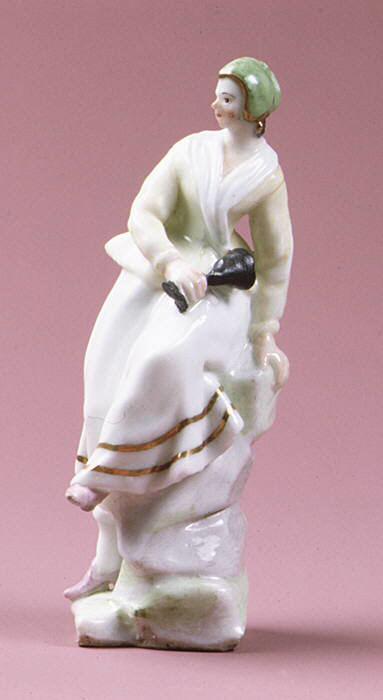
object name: figure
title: Tipsy woman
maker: capodimonte porcelain manufactory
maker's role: manufactory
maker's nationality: italian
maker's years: 1740-1759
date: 1745-1750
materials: soft paste porcelain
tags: women